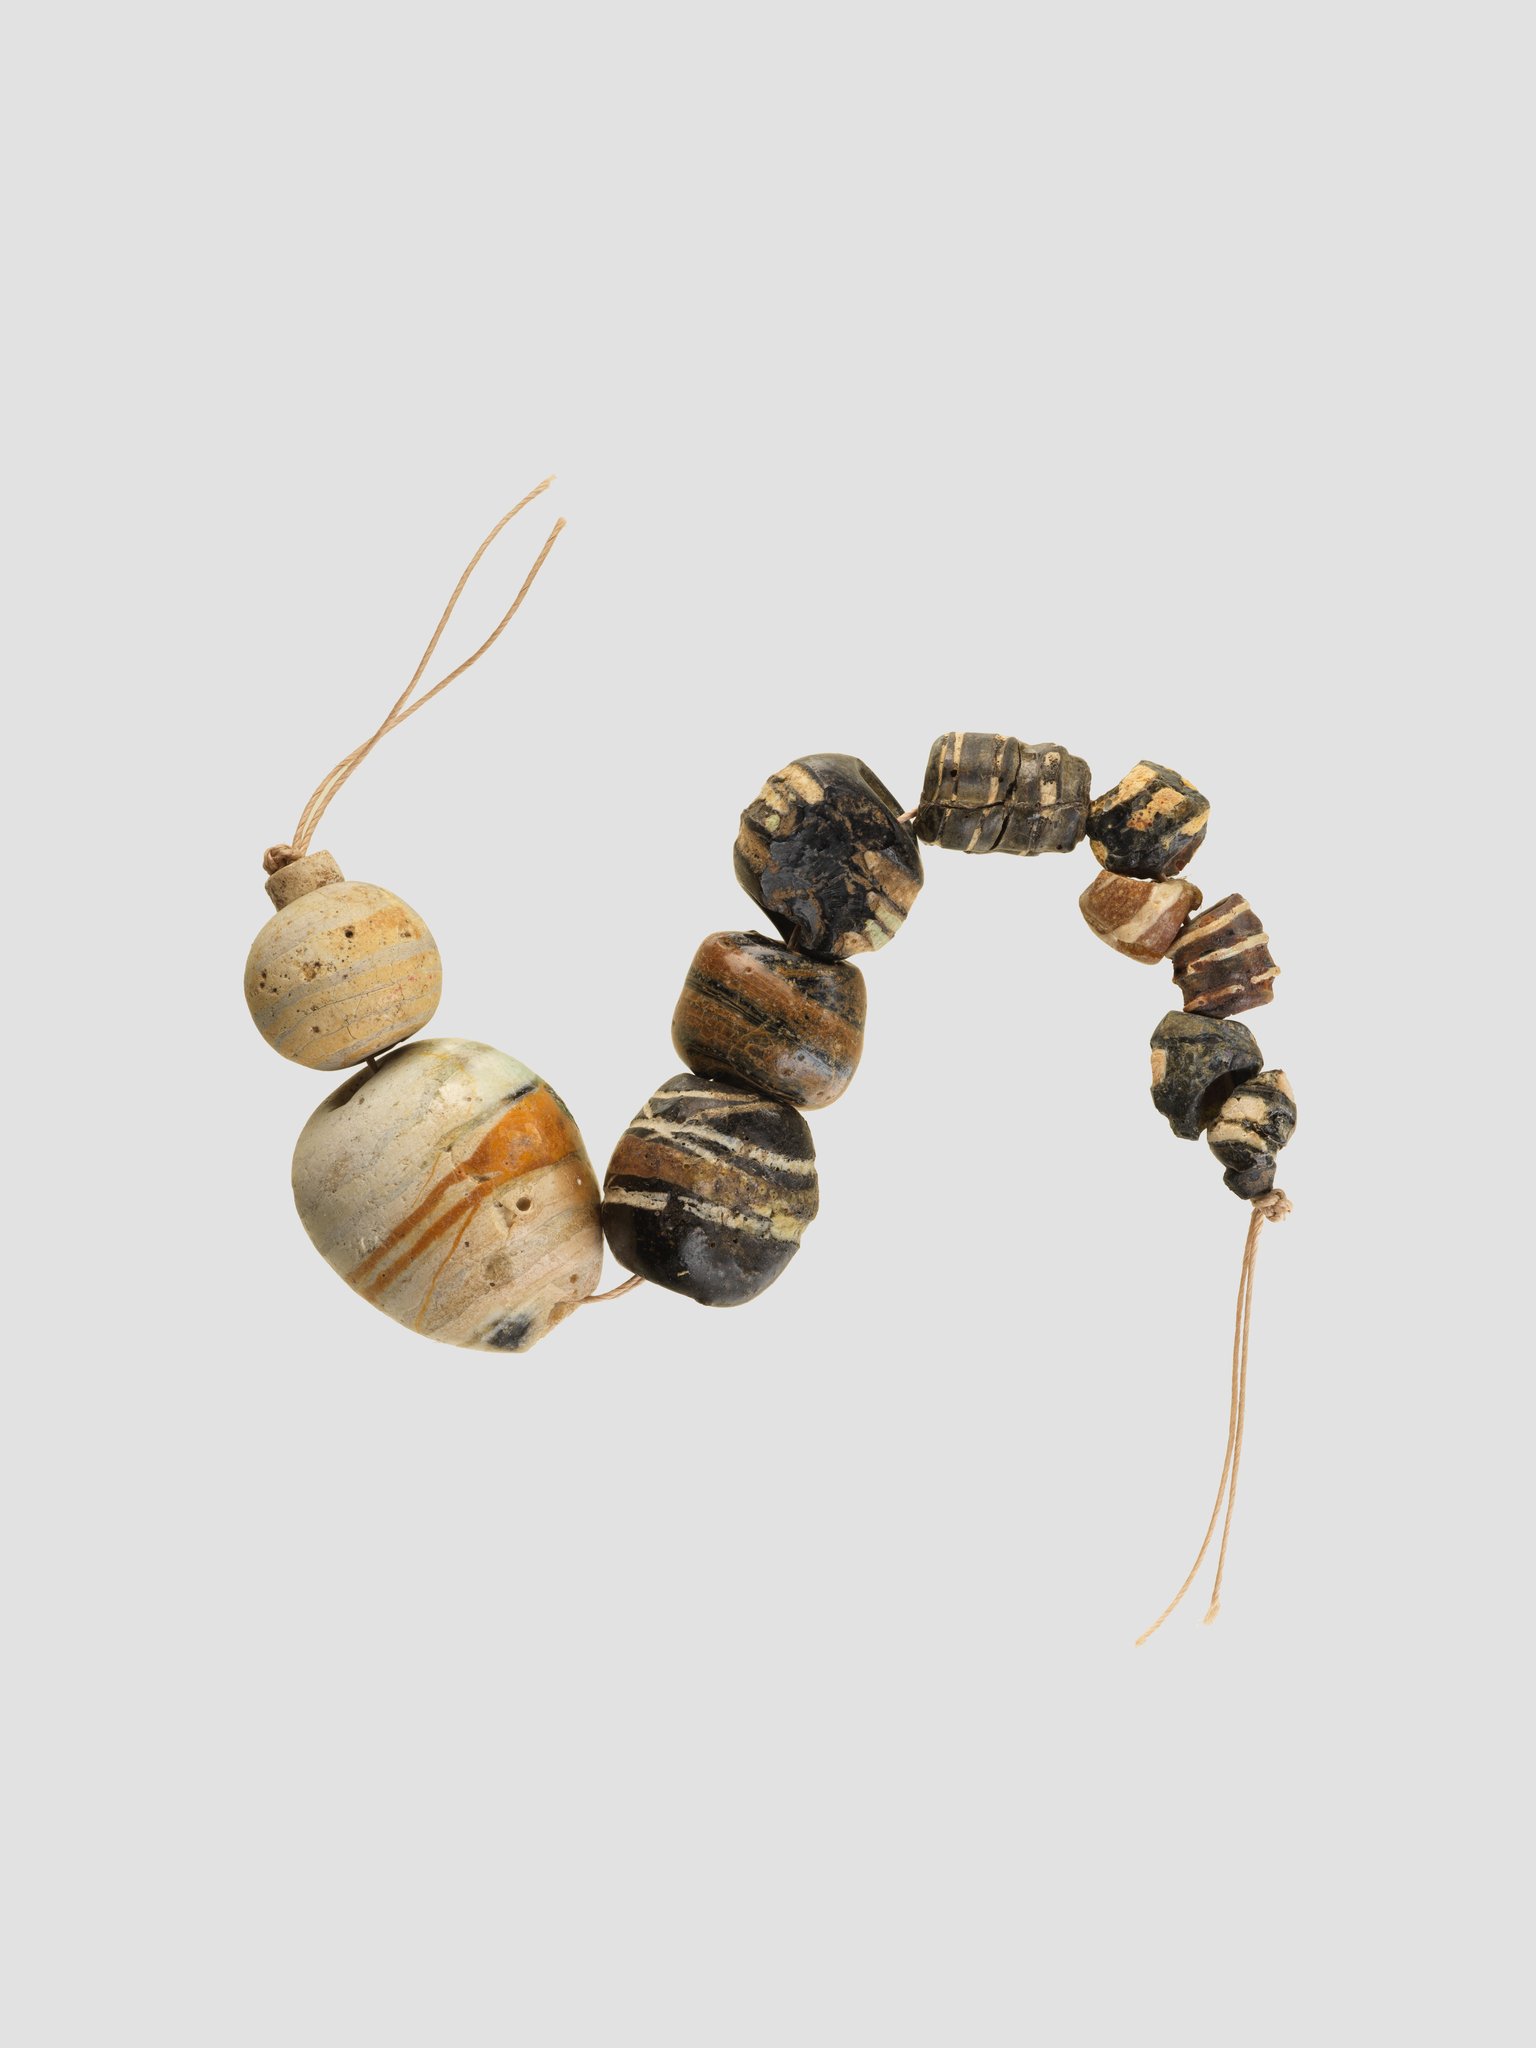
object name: bead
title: Beads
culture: iranian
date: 900-801 BCE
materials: glass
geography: iran